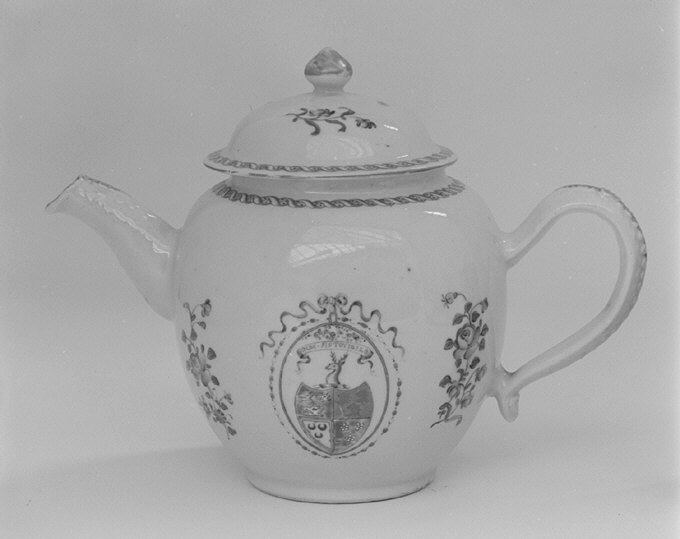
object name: teapot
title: Teapot (part of a service)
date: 1770-1785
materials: hard paste porcelain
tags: flowers,coat of arms